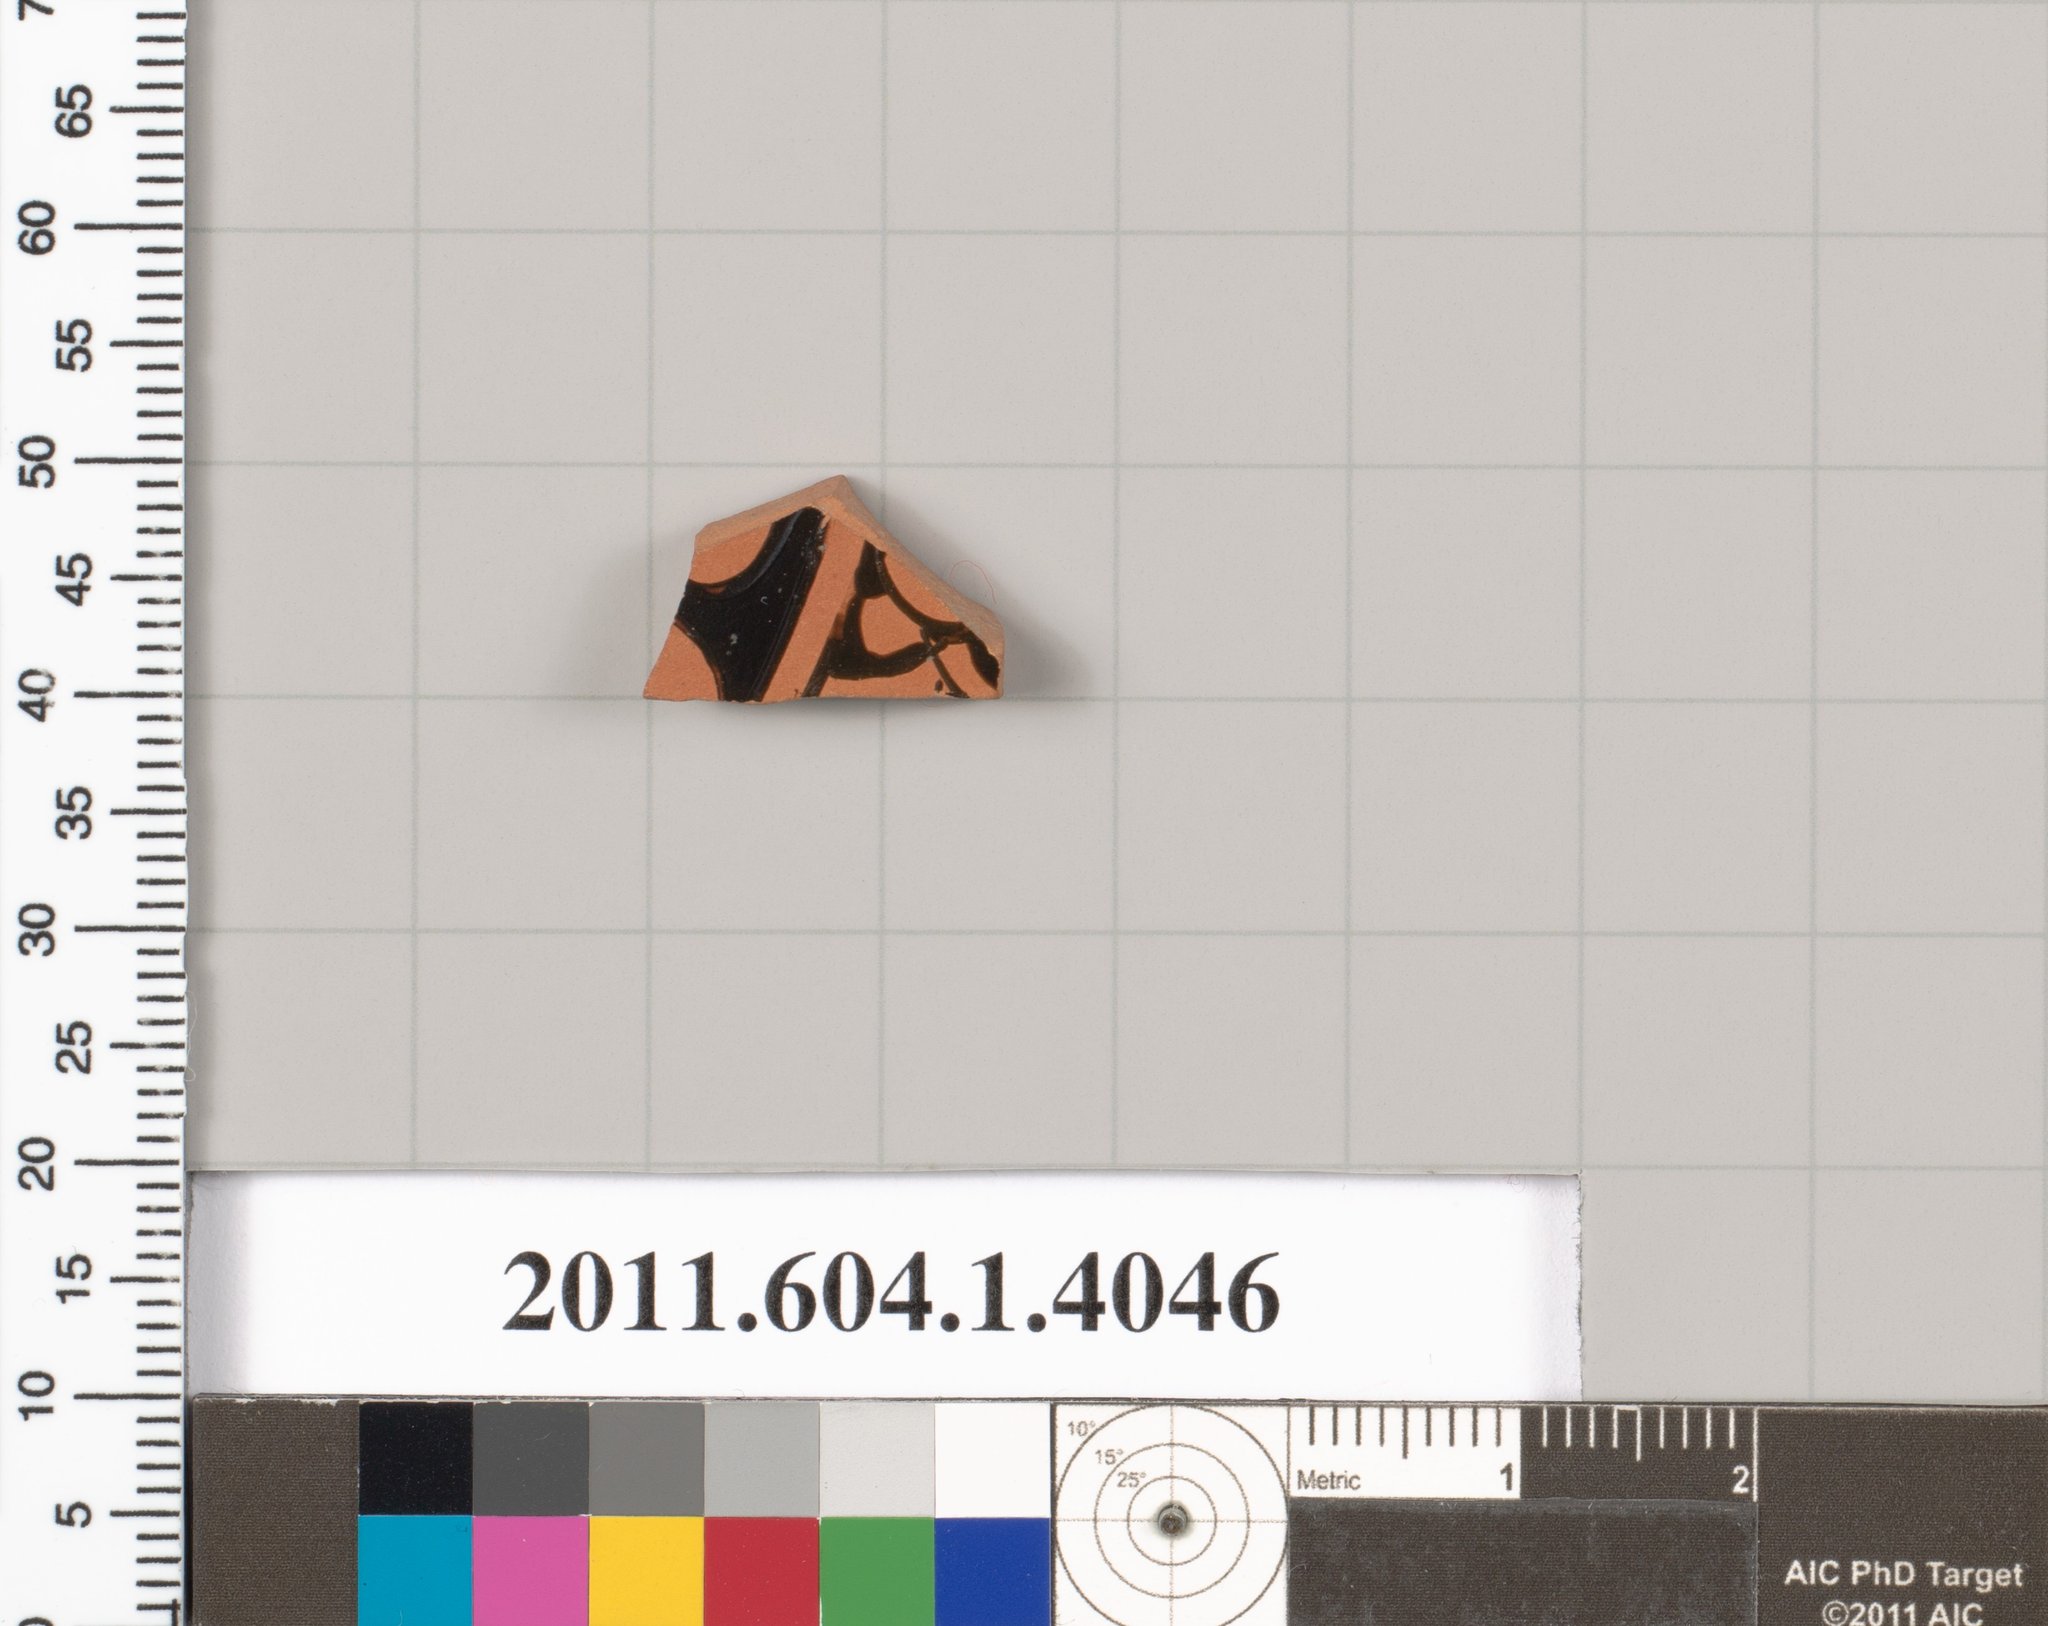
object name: kylix fragment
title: Terracotta fragment of a kylix (drinking cup)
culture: greek, attic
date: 534-468 BCE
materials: terracotta